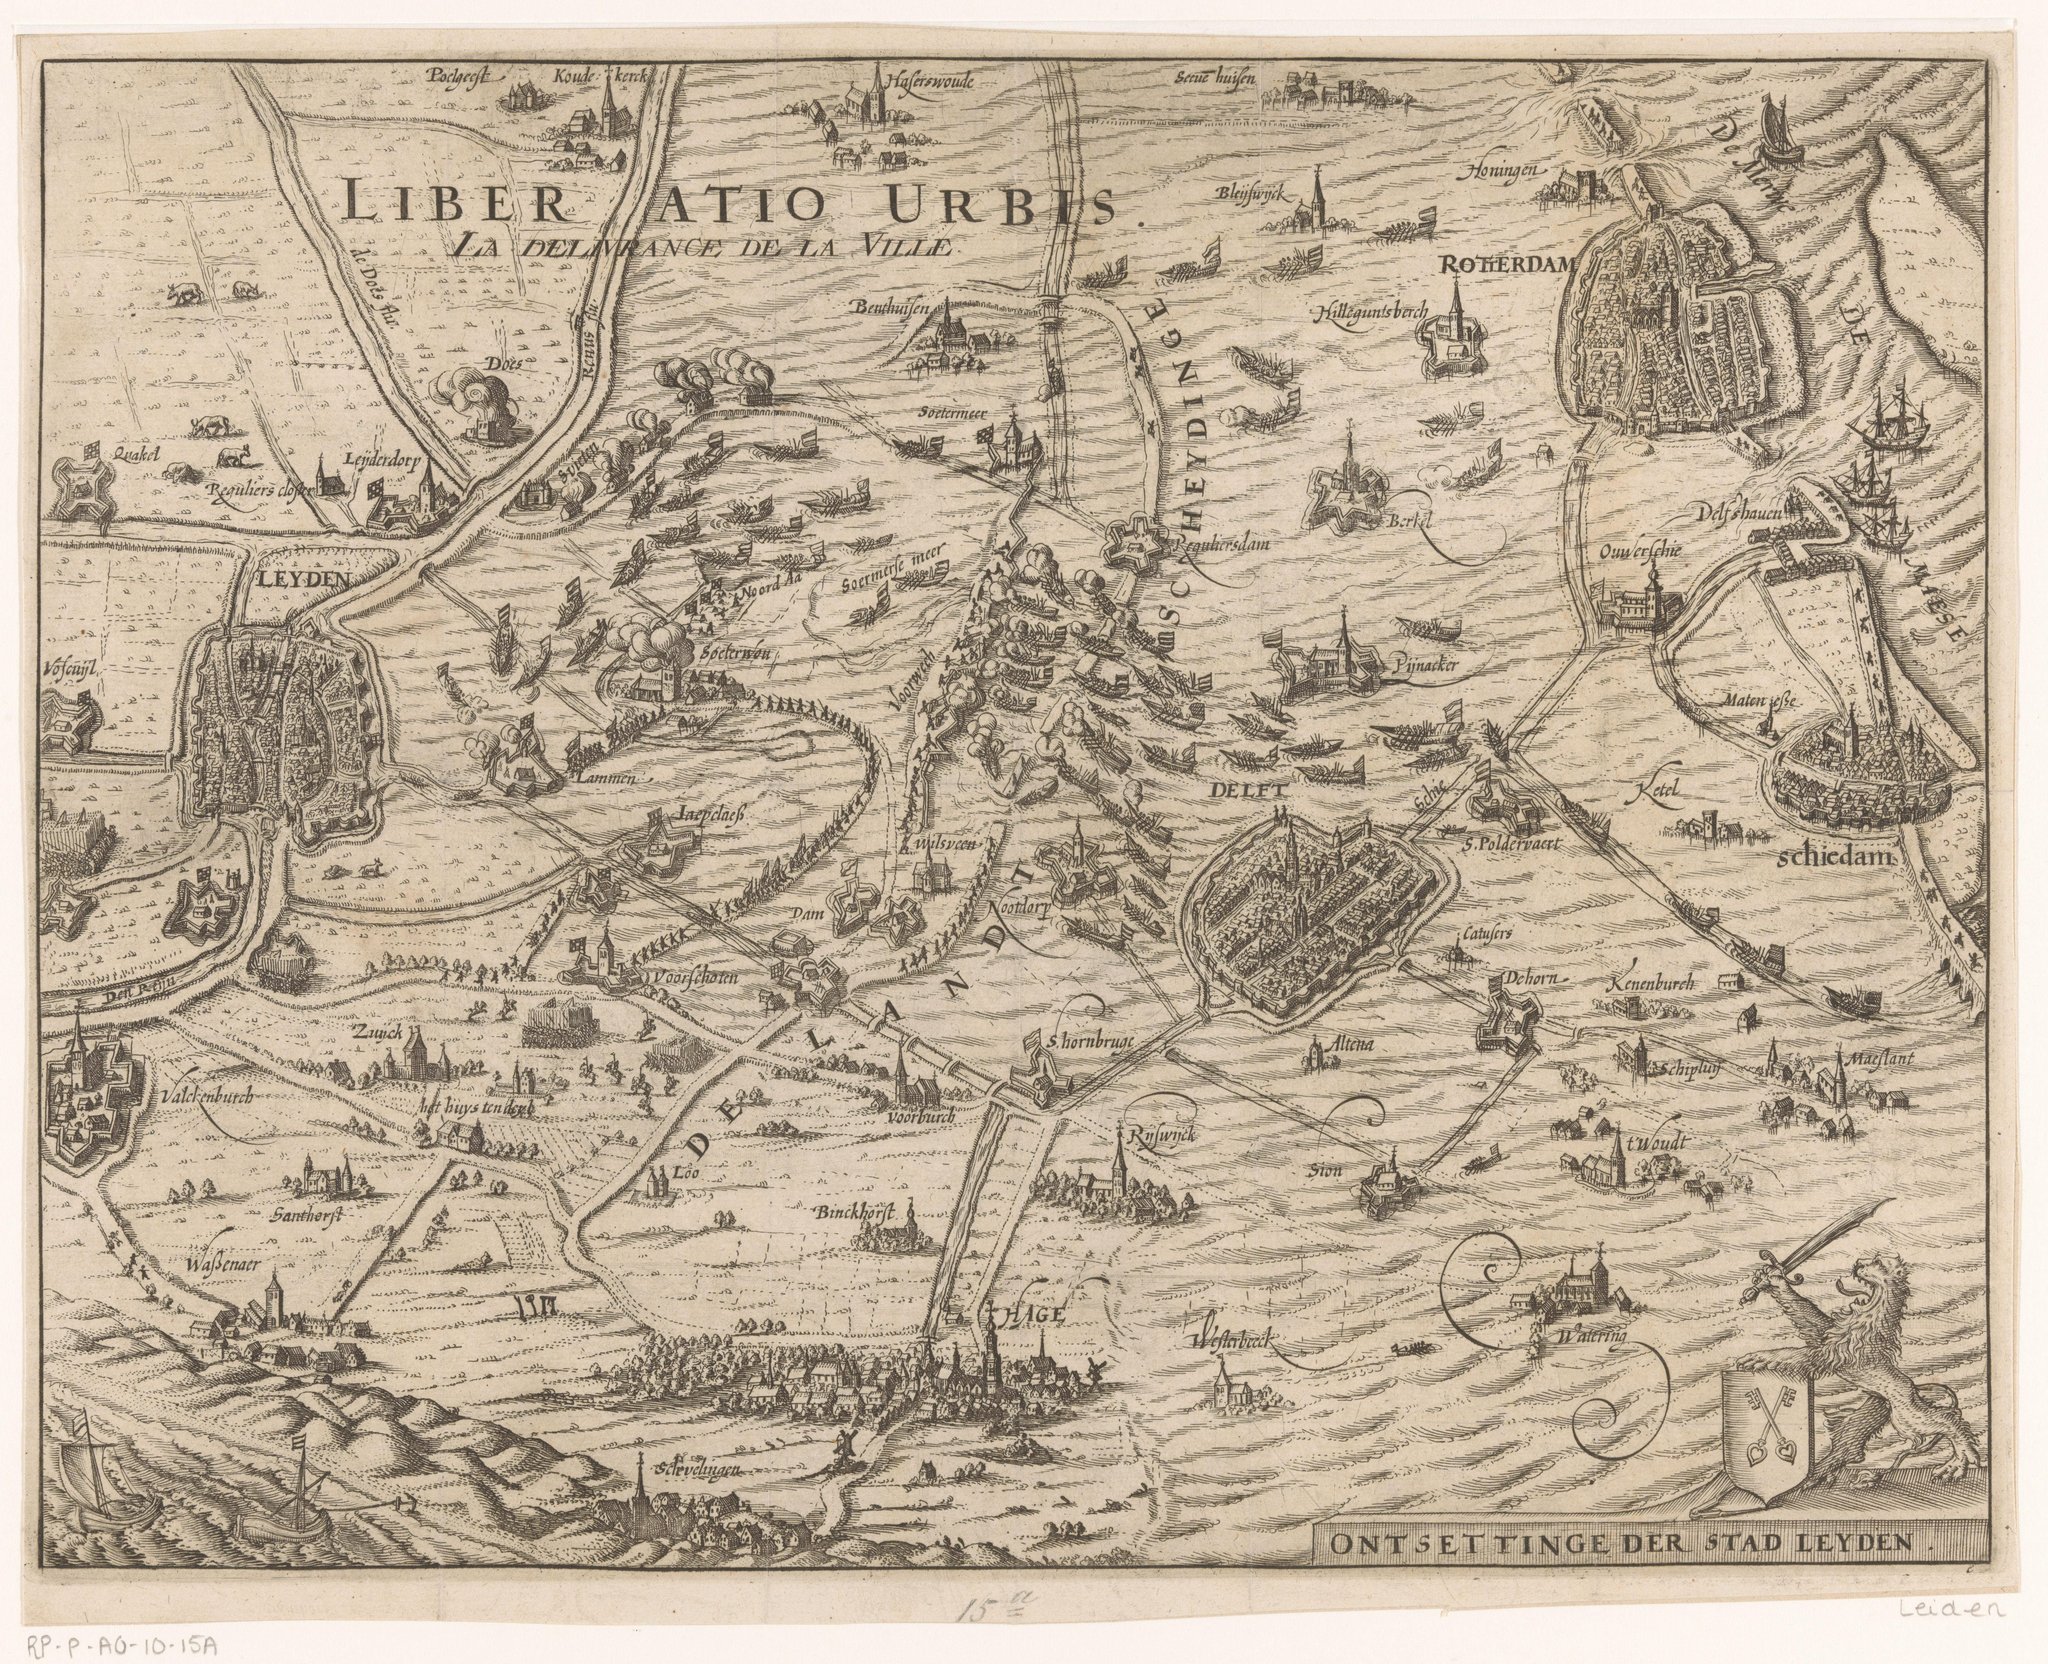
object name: history print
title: Kaart met het ontzet van Leiden, 1574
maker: Anonymous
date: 1625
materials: paper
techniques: engraving, etching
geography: northern netherlands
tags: raising the siege with outside assistance, relief, maps of separate countries or regions, leiden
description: Prent ook gebruikt in: Meurs, Johannes van. Athenae Batavae. Sive, de urbe Leidensi & Academia, virisque claris; qui utramque ingenio suo, atque scriptis, ilustrarunt. 2 delen. Leiden: Andries Clouck en Elzevier, 1625, dl. 2.